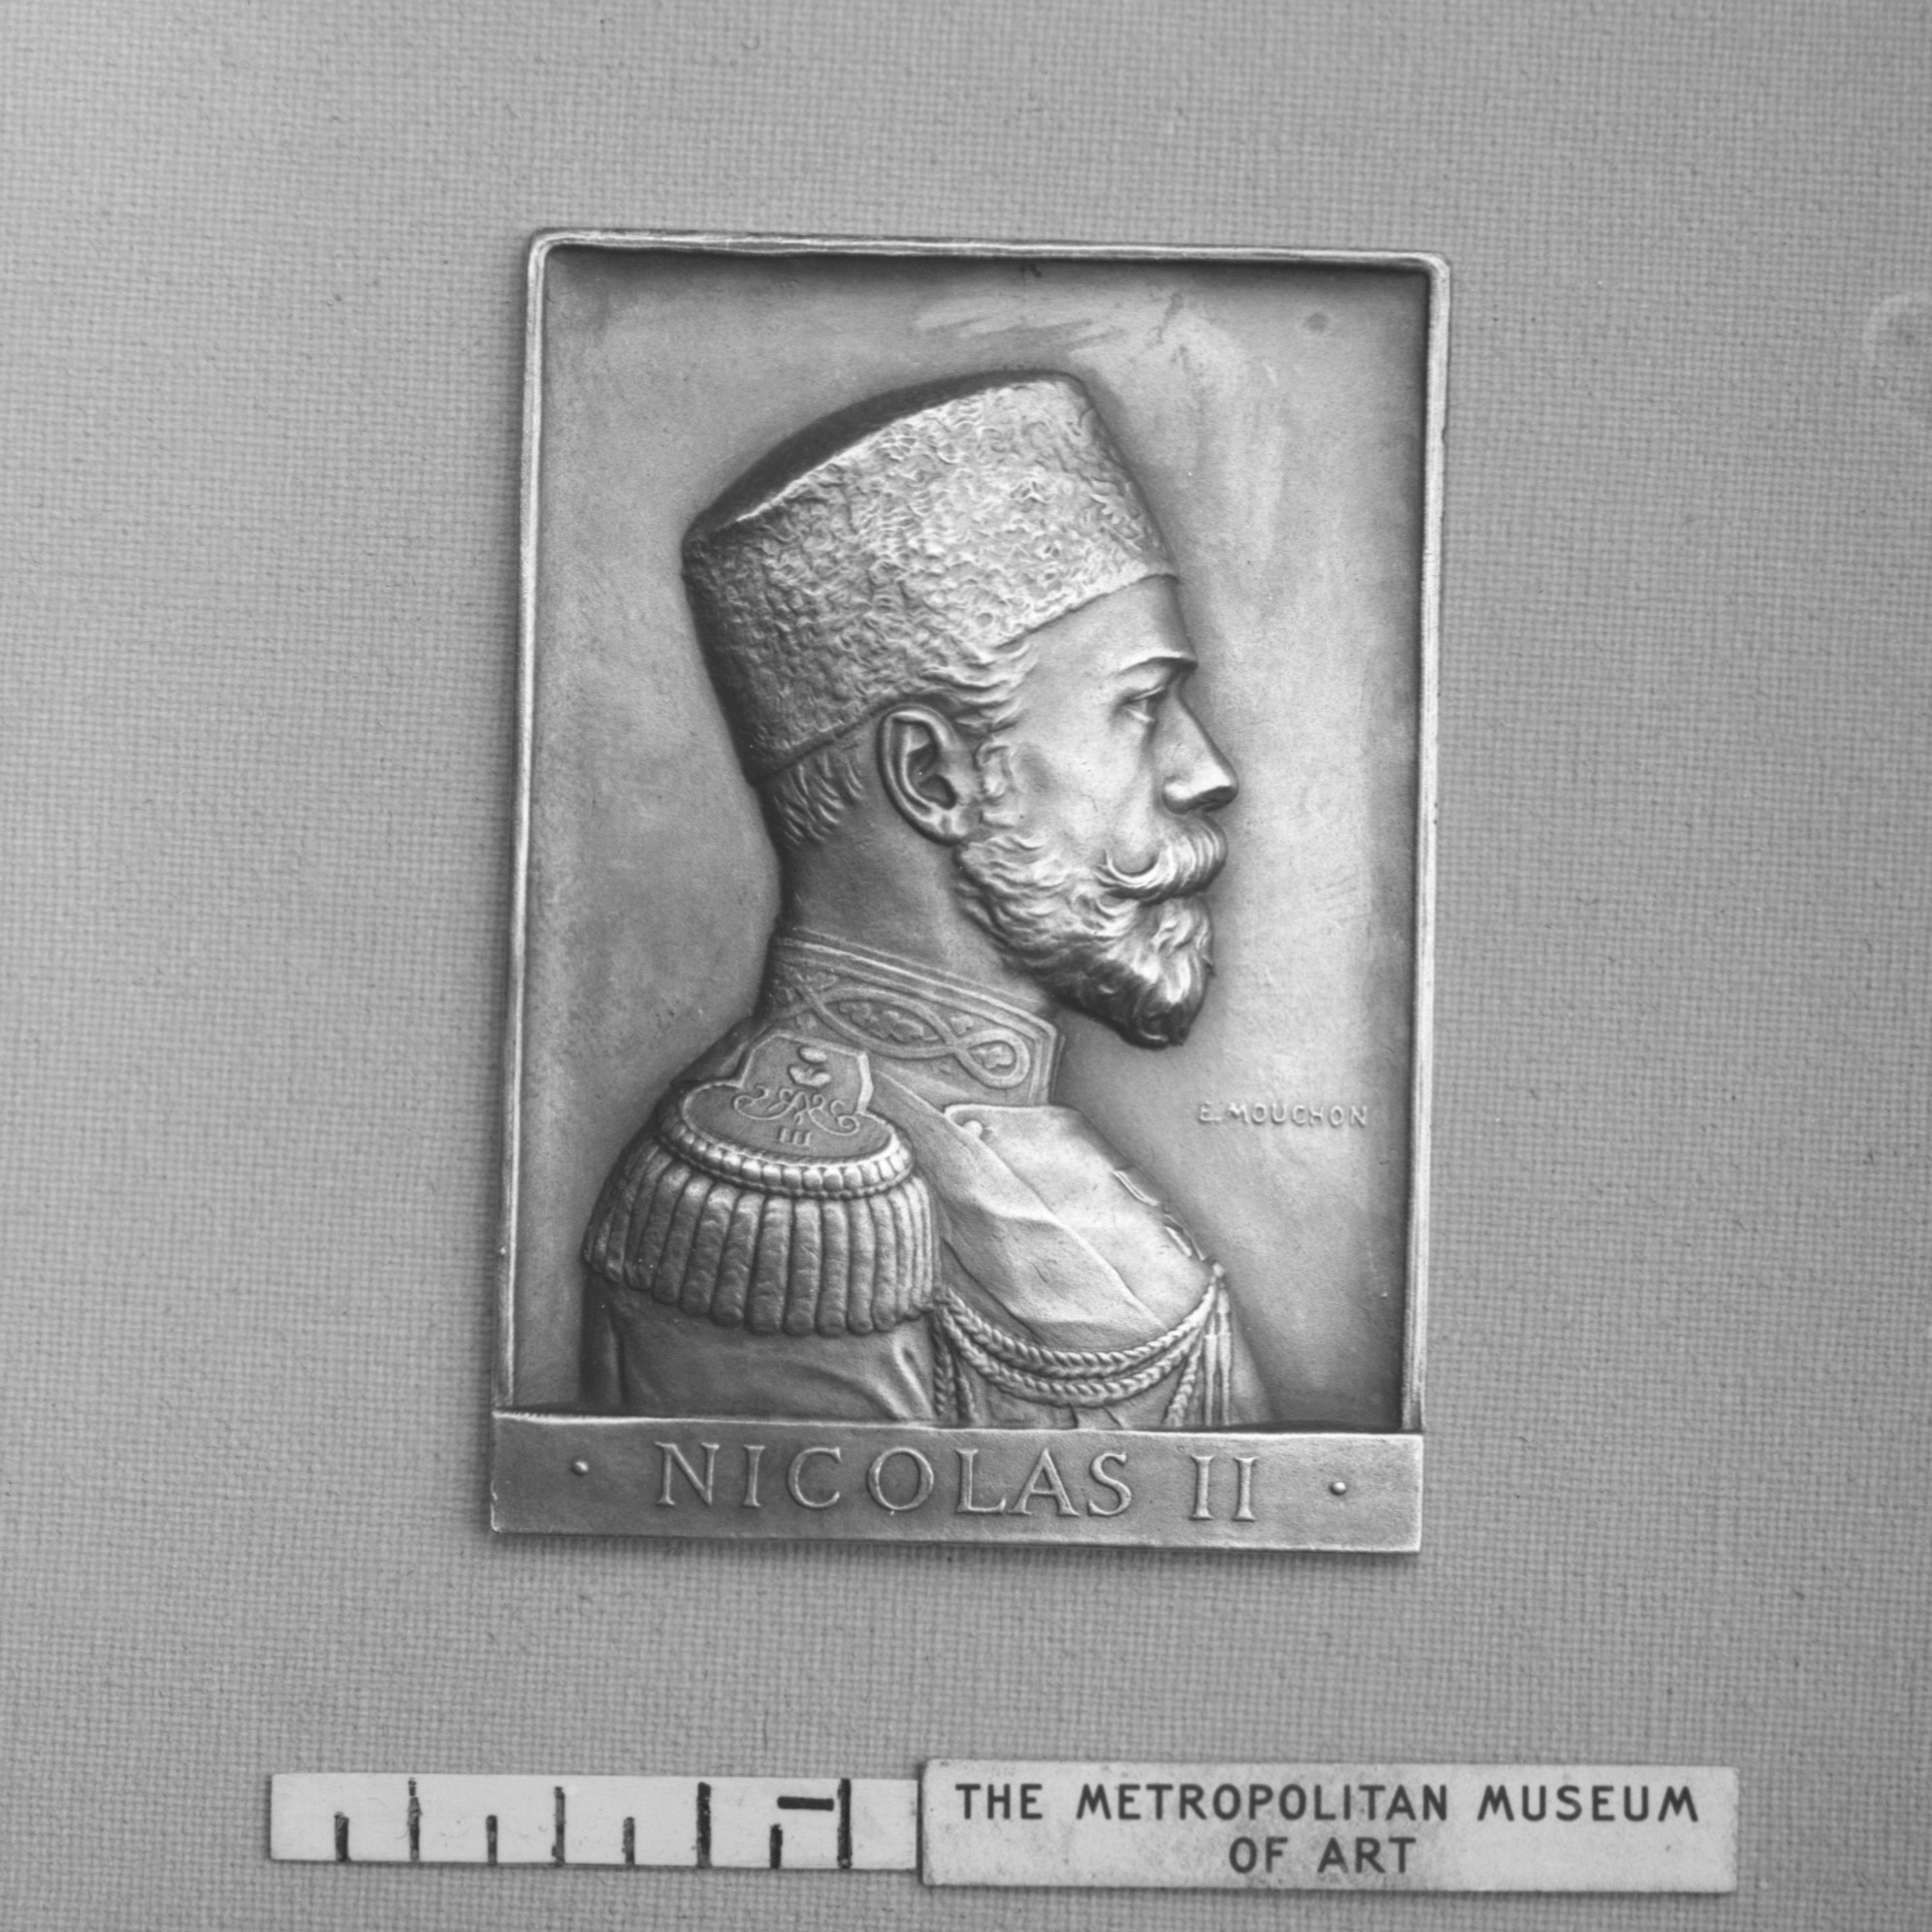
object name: plaquette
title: To Commemorate the Visit of the Tsar Nicholas II and the Tsaritsa to Paris in 1902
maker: louis eugène mouchon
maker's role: artist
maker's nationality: french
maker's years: 1843-1914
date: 1902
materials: bronze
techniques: silvered, struck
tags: men,profiles